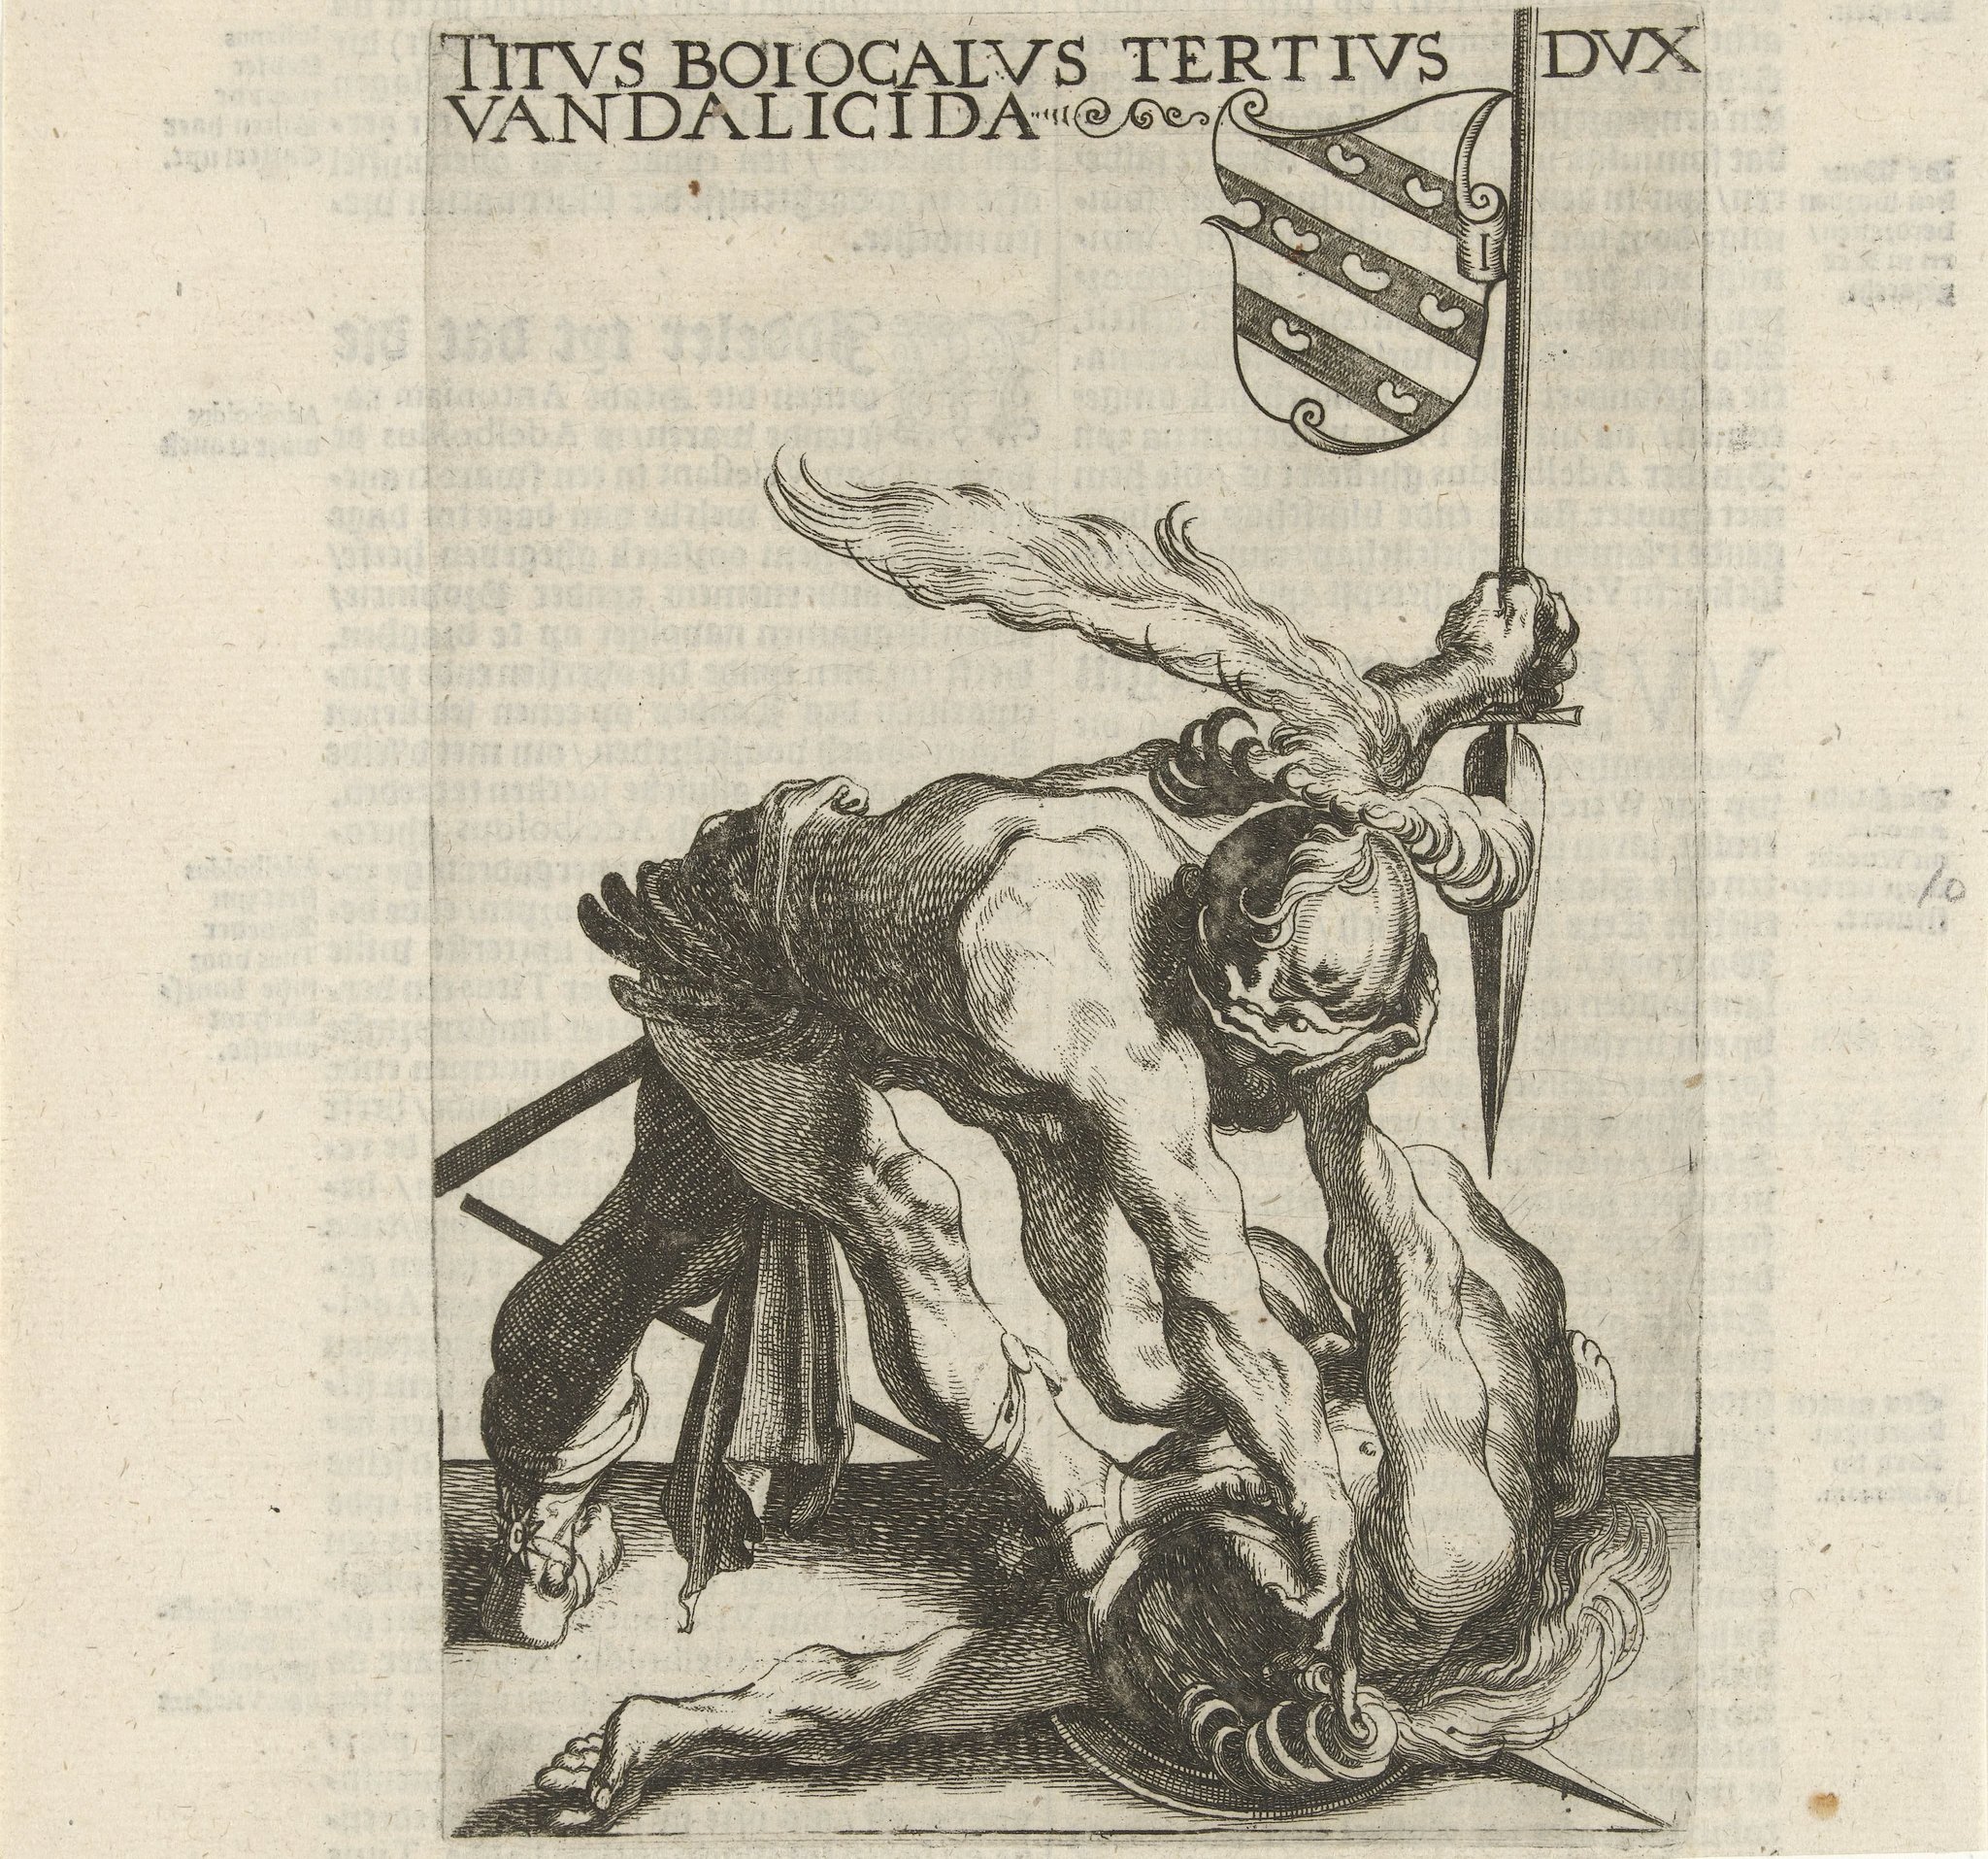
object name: print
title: Titus Bojocalus tertius dux vandalicia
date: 1622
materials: paper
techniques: etching, letterpress printing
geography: franeker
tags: titus bojocalis (hertog der friezen)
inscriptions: collector's mark: Lugt 2228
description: De prent is ook als boekillustratie gebruikt in: Winsemius, P.W. Chronique ofte Historische geschiedenisse van Vrieslant (...). Franeker: Joannes Lamrinck, 1622.